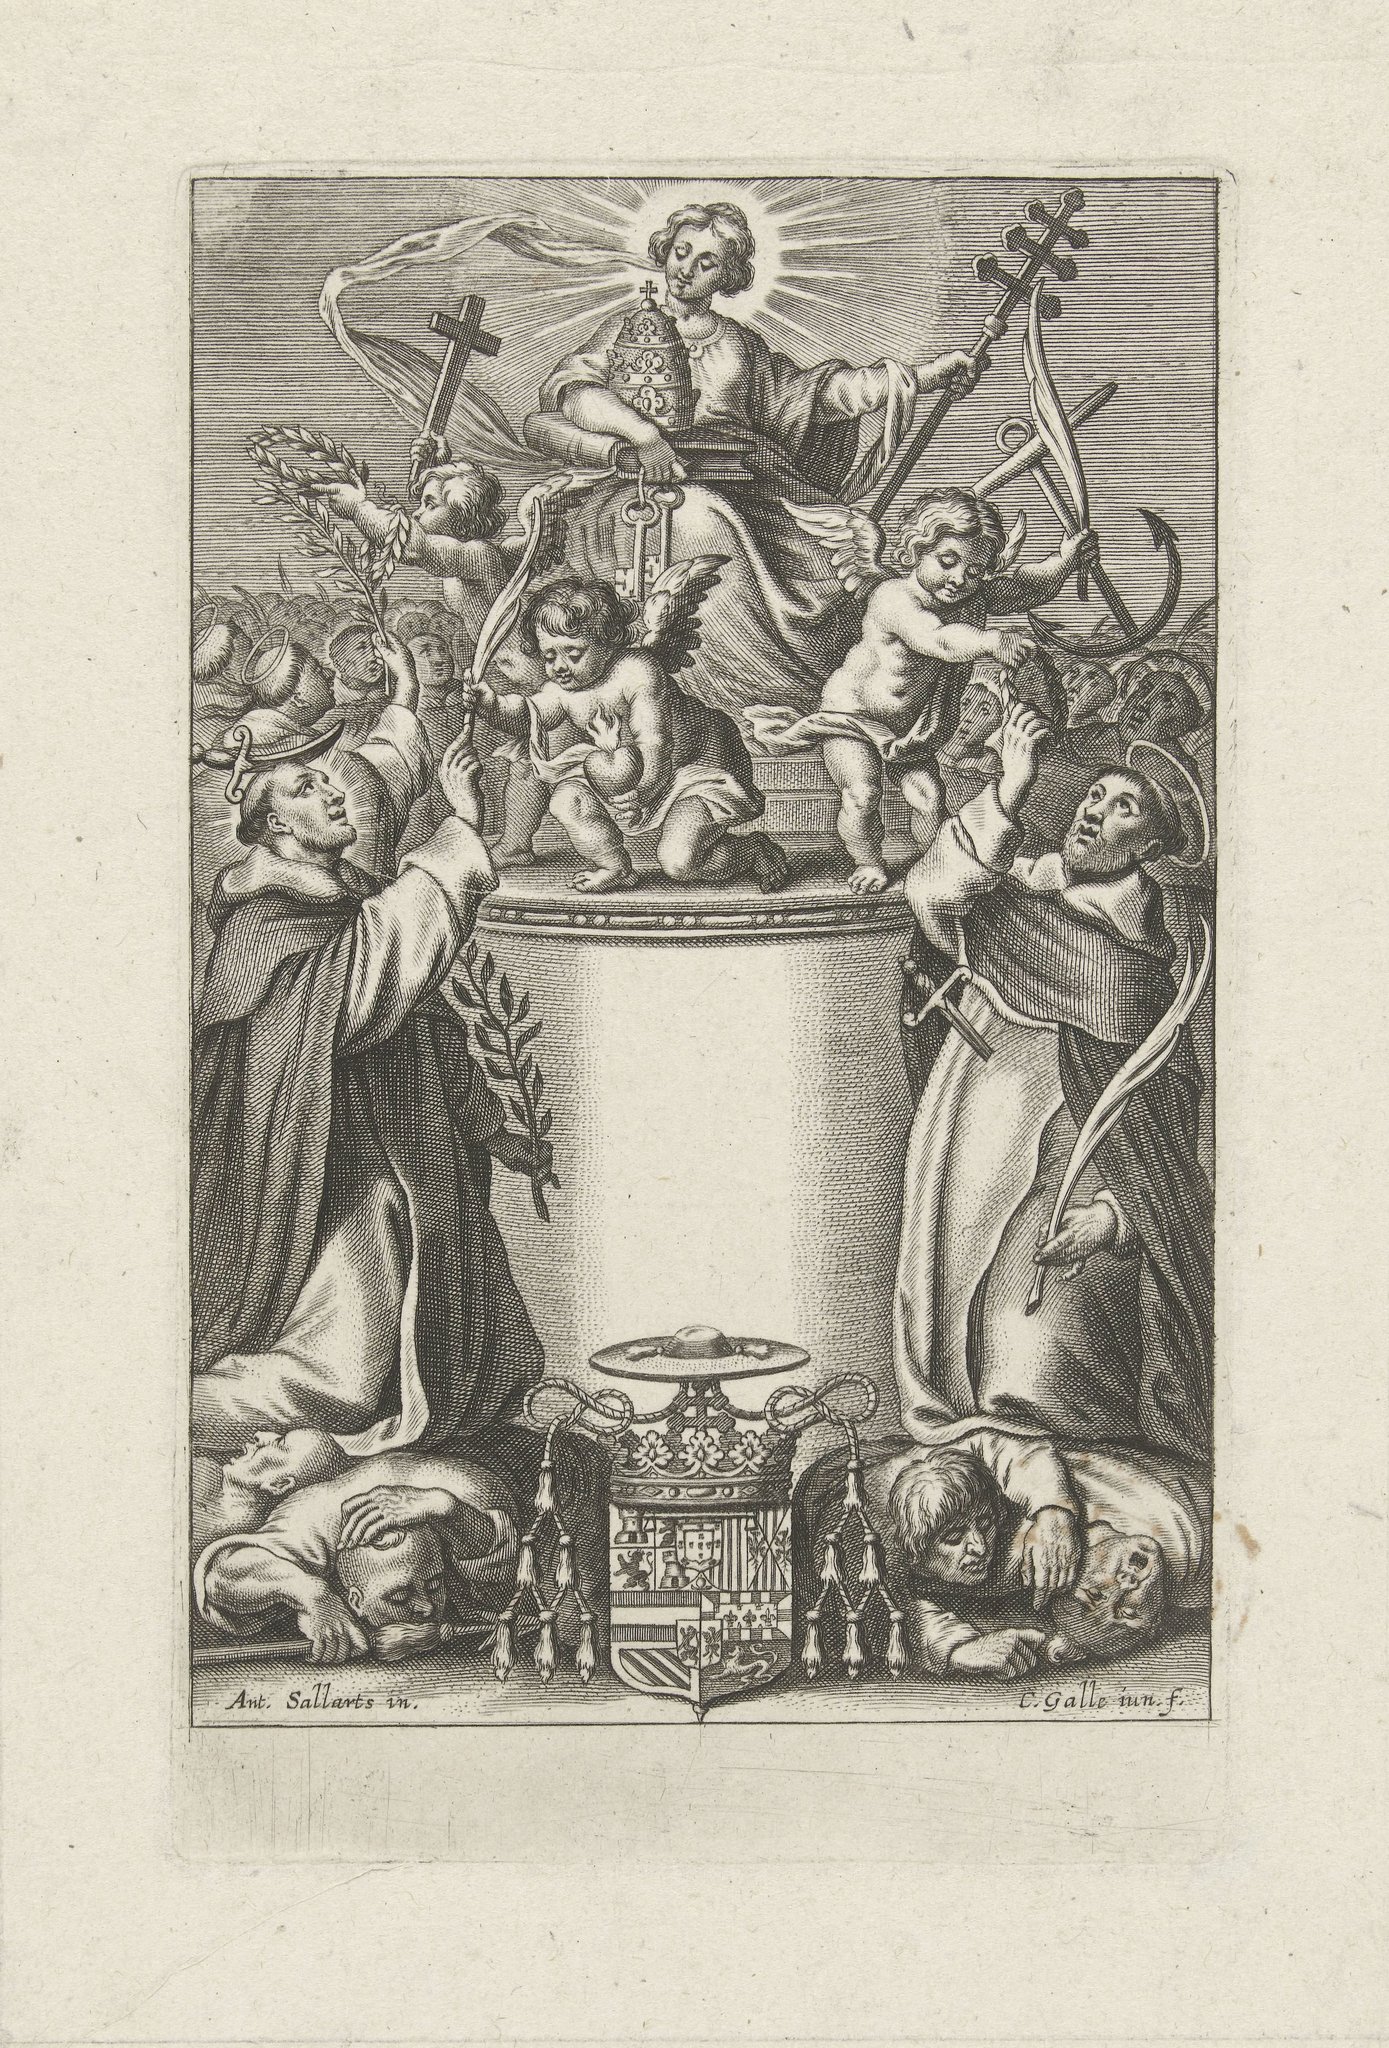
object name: titelblad, titelpagina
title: Allegorische titelpagina met twee Dominicaanse martelaren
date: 1638-1650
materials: paper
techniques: engraving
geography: antwerp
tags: saints, monastic orders, monastic life: dominicans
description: Twee Dominicaanse martelaren worden gelauwerd. De een heeft een sabel op zijn hoofd, de ander een zwaard in zijn borst. Op een troon zit in het midden de personificatie van het pausdom, met tiara en sleutels. Twee engelen overhandigen de martelaren een lauwerkrans en een palmtak. Op de achtergrond een grote menigte.